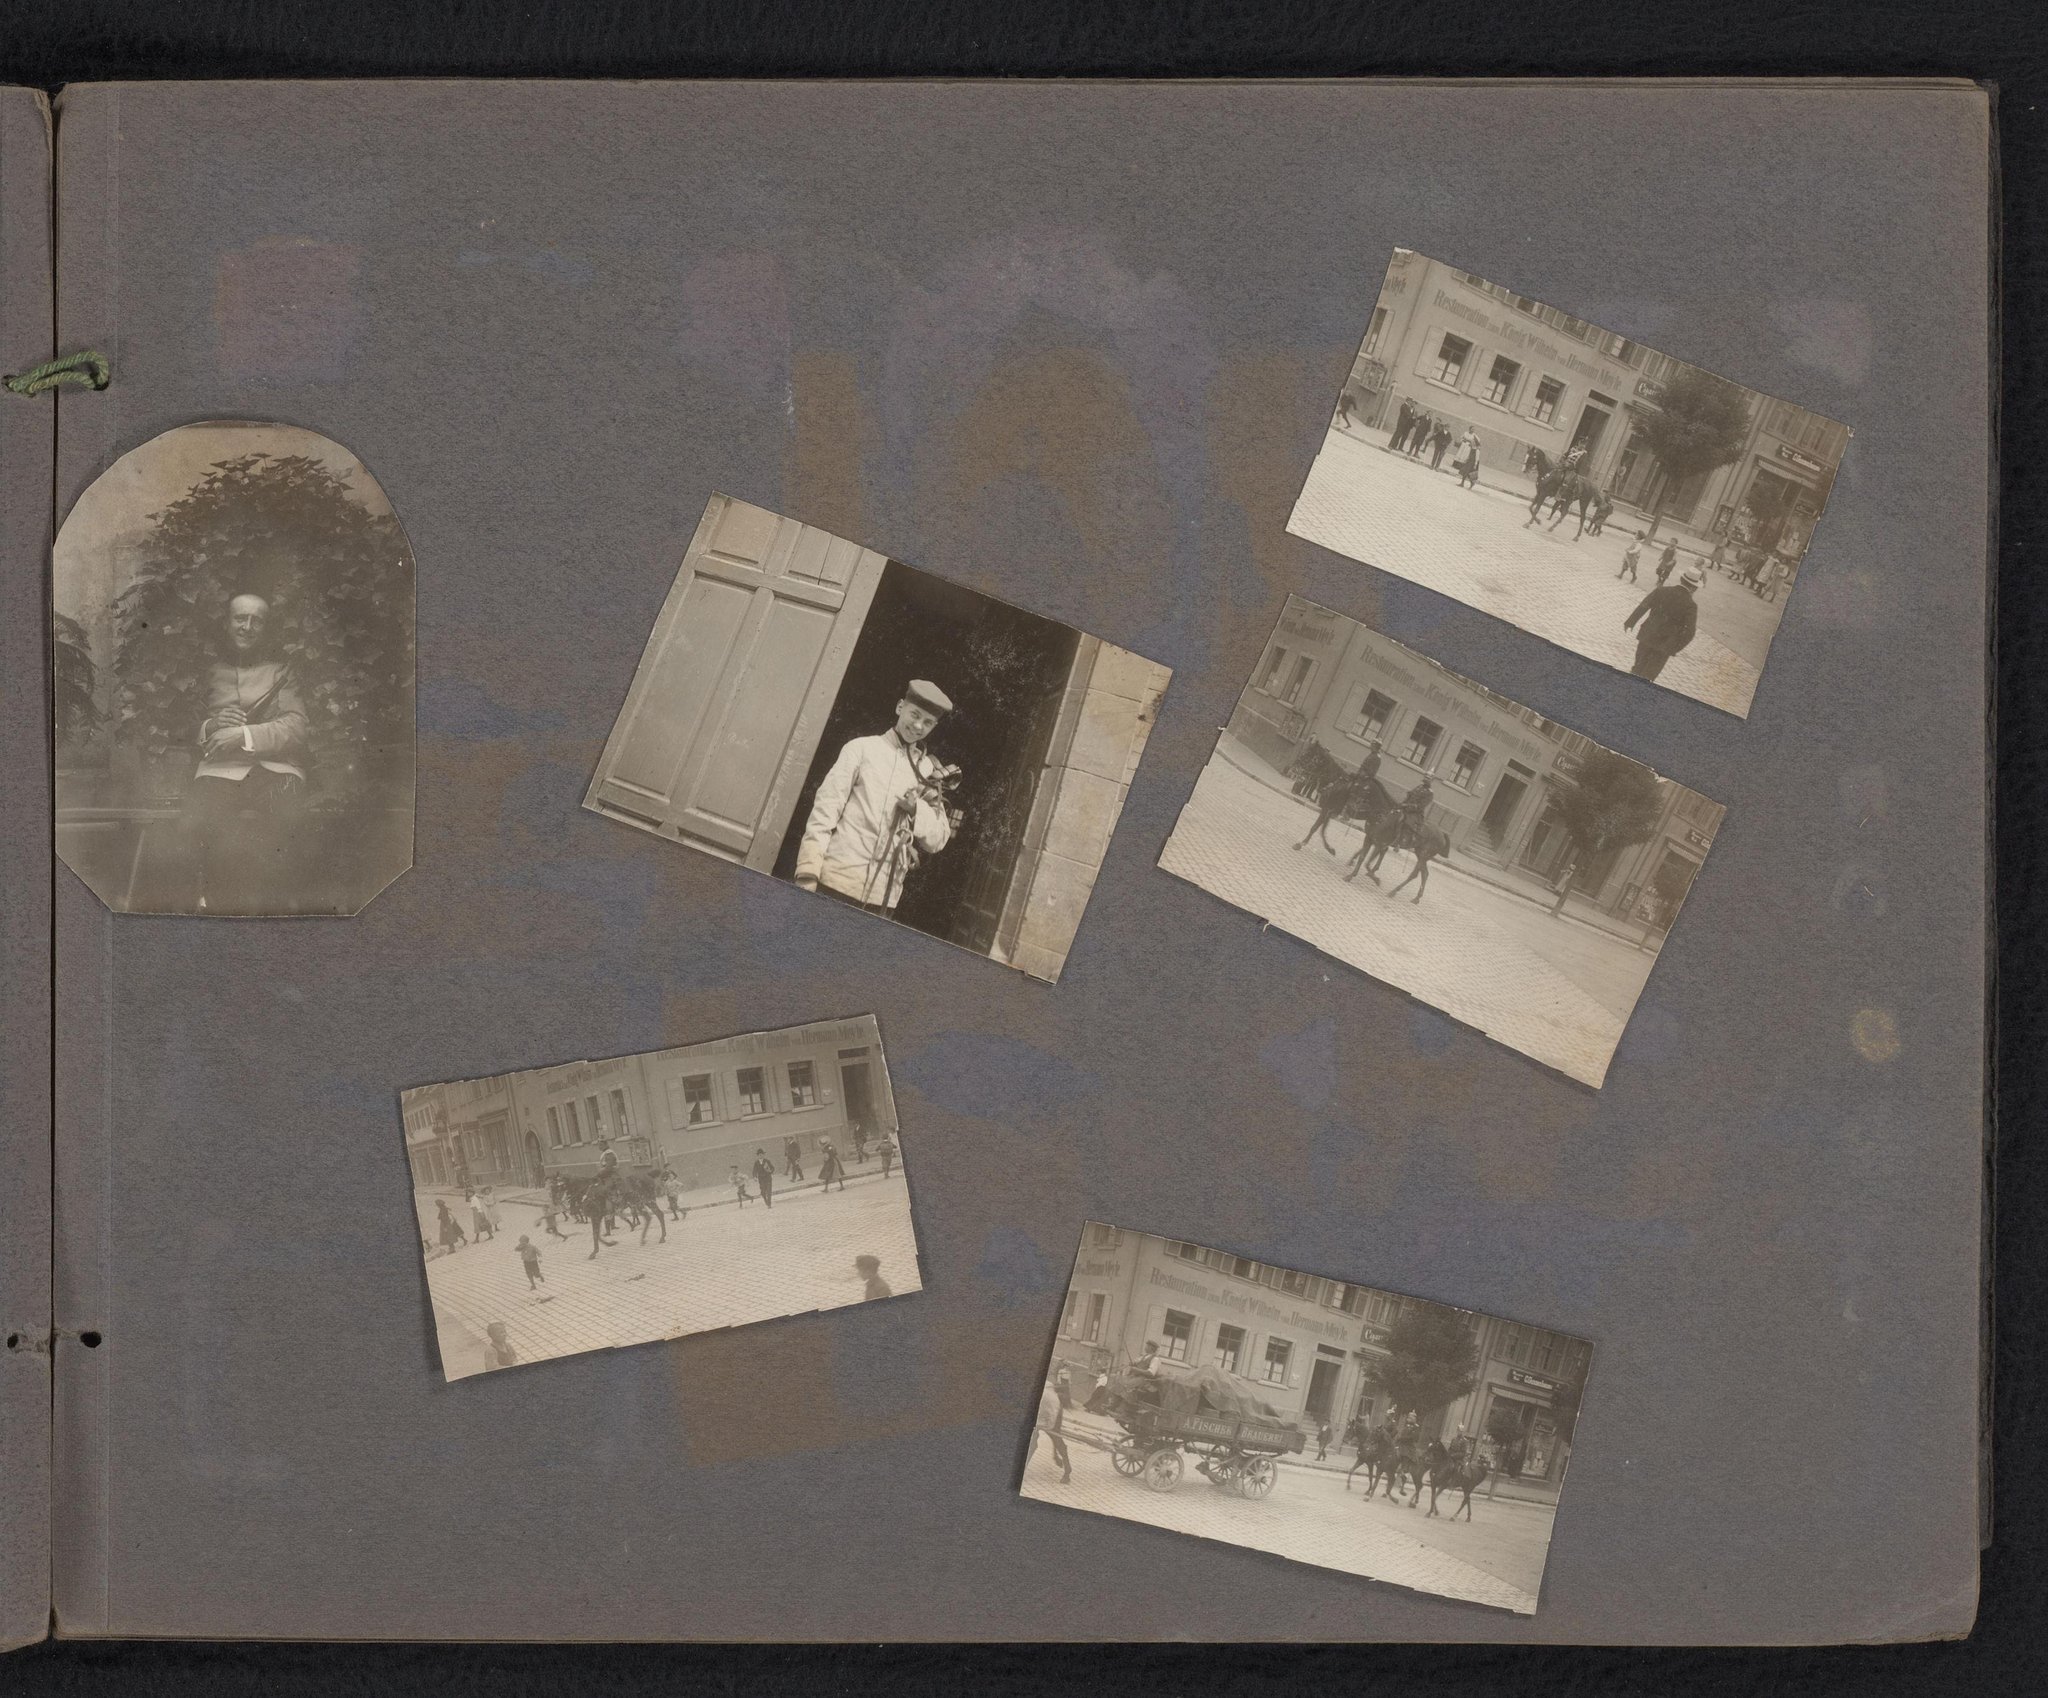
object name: album leaf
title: Militairen te paard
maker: Anonymous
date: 1905-1906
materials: cardboard, photographic support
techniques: gelatin silver print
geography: germany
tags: arthur moos, military training, public road, germany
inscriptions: inscription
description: Albumblad met zes losse foto's van militairen te paard in de straat en twee onbekende personen. Losse foto's bij dit blad in het fotoalbum van Arthur Moos tijdens zijn militaire diensttijd bij het 20e regiment Ulanen, Ludwigsburg, 1905-1906.